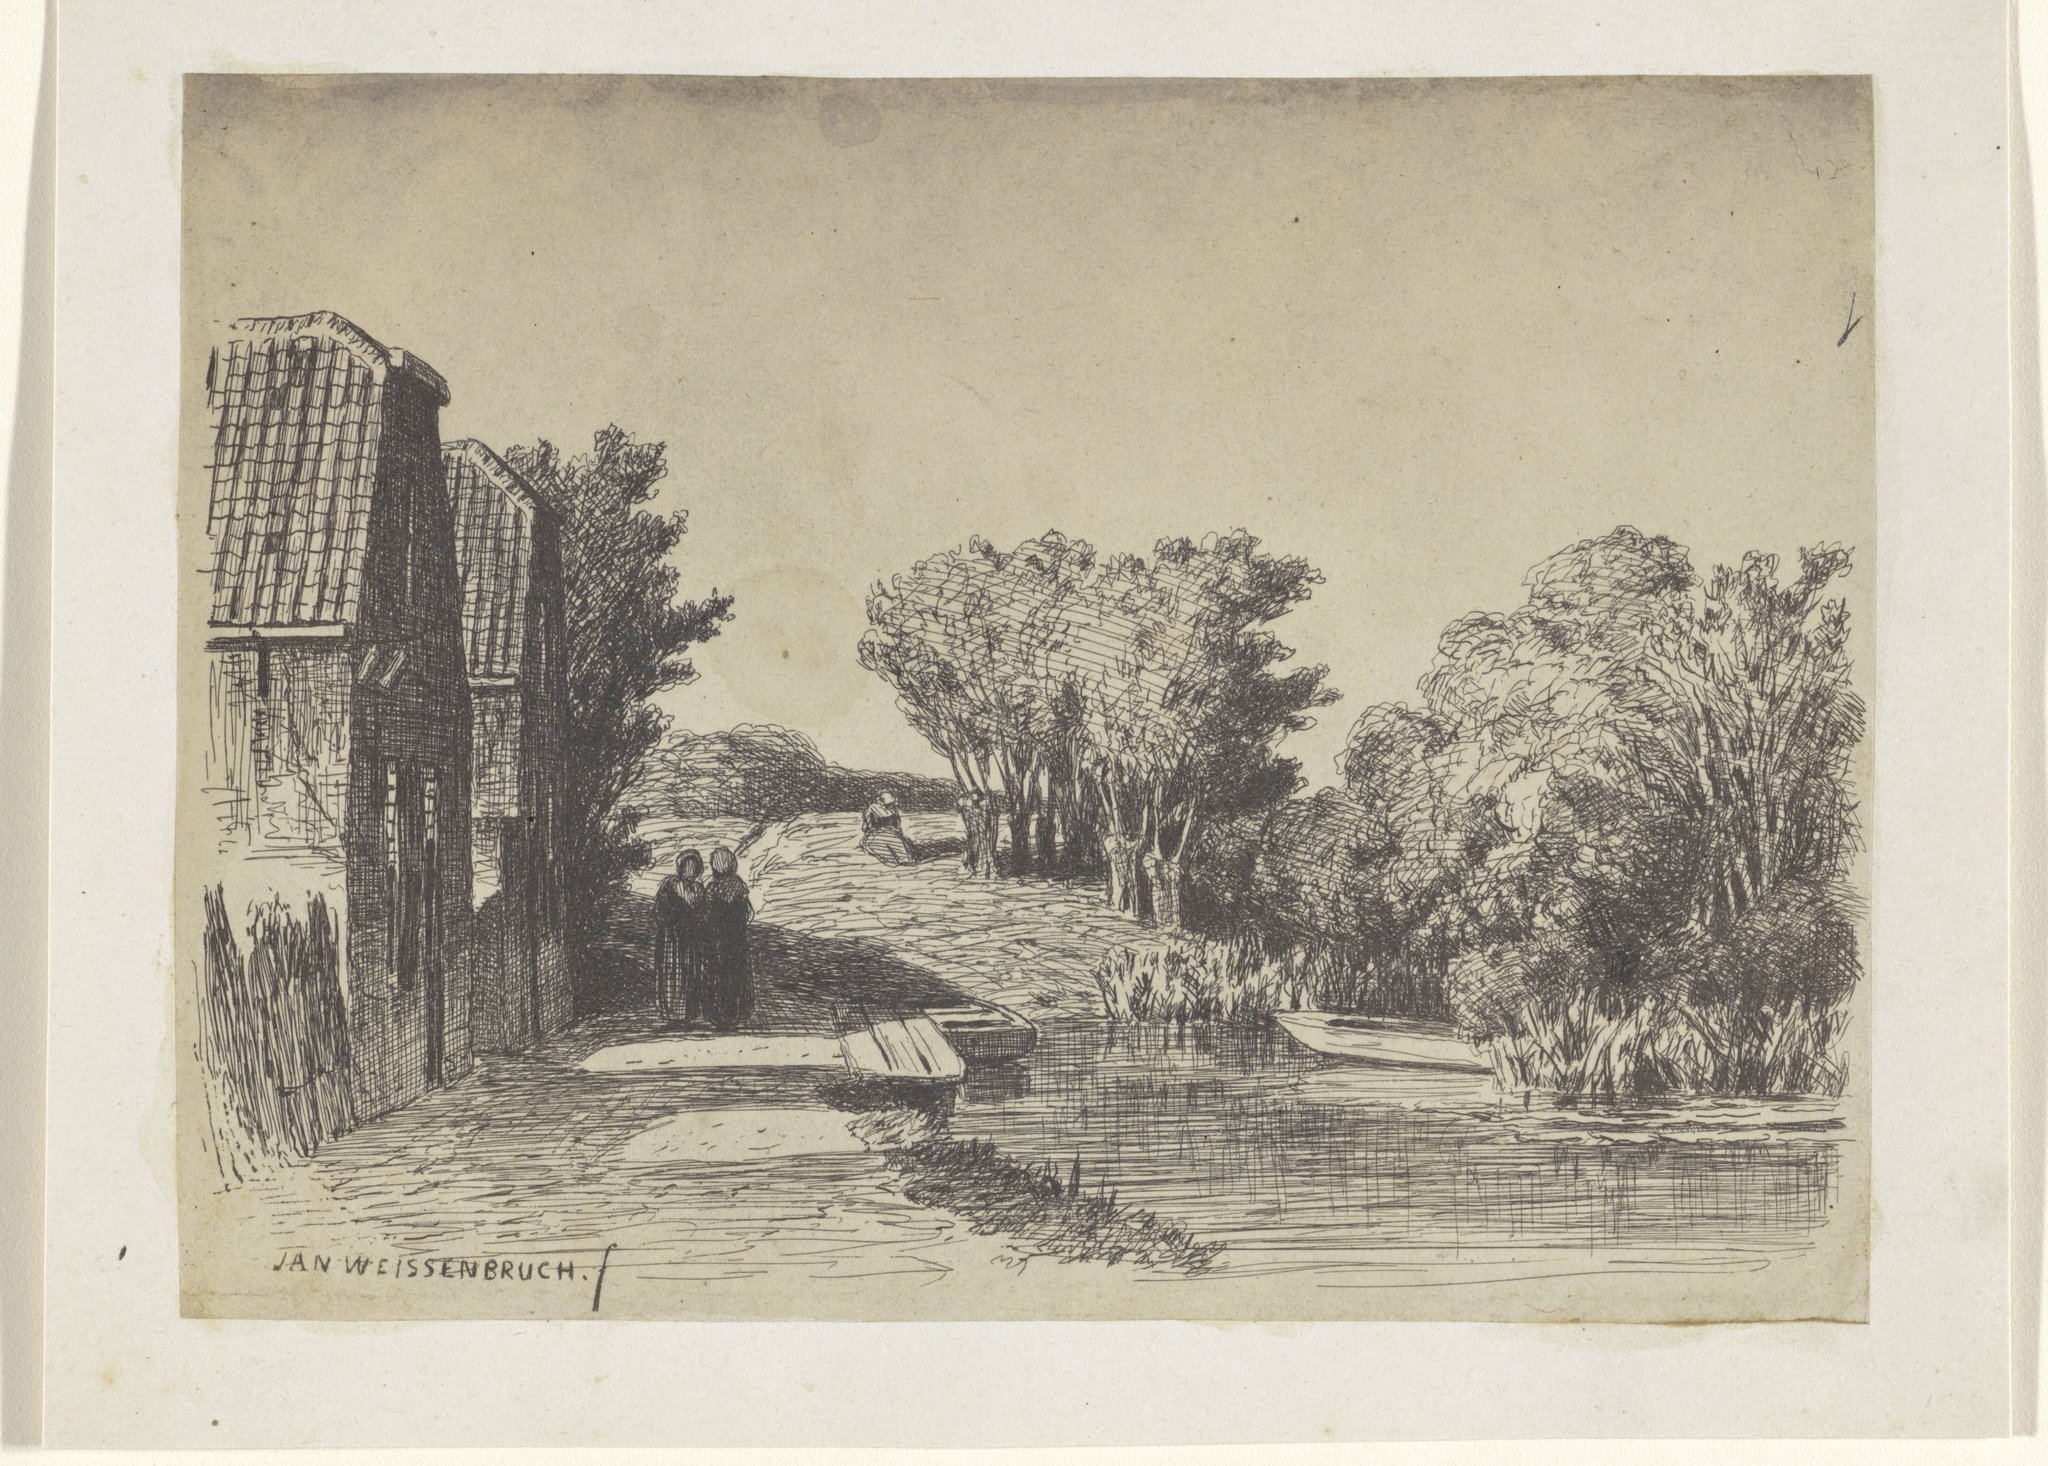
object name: photograph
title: Twee huizen aan het water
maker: jan weissenbruch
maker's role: painter, print maker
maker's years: 1822-1880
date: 1837-1880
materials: paper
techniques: cliché verre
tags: adult woman, river, landscapes with waters, waterscapes, seascapes (in the temperate zone), rural housing, e.g. country-house, villa, cottage, rowing-boat, canoe, etc.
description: Op de oever van een rivier staan twee huizen. Voor de huizen staan twee vrouwen. In het water liggen twee boten.